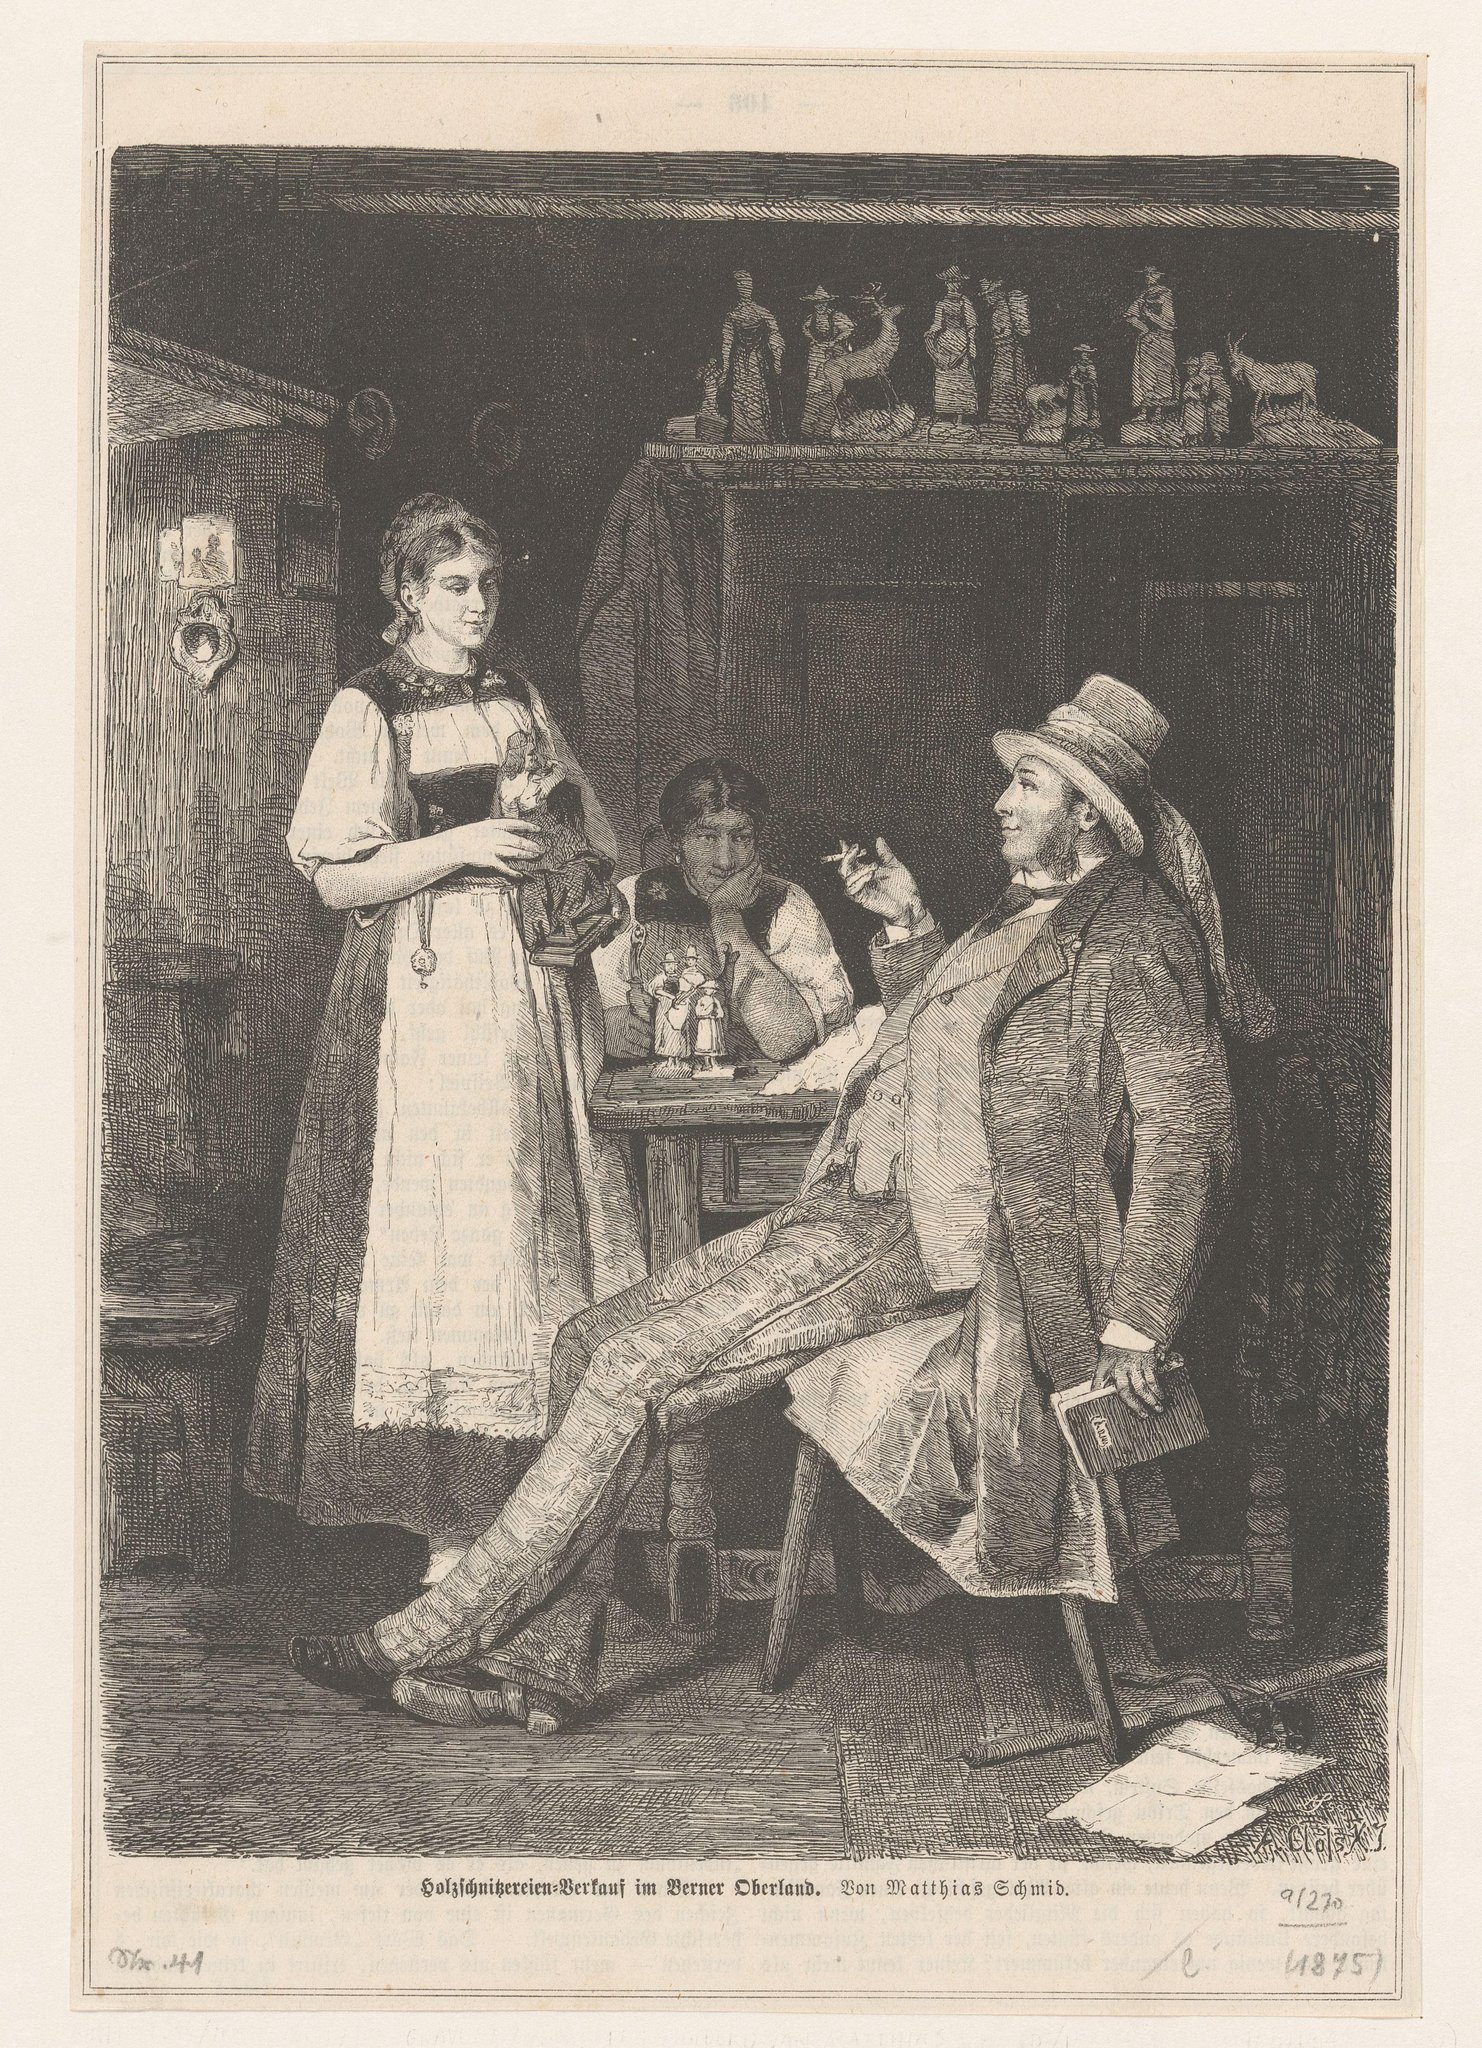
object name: print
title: Verkoper van houten beelden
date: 1850-1894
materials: paper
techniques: engraving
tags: work of applied art, merchant, salesman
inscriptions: collector's mark: Lugt 2228